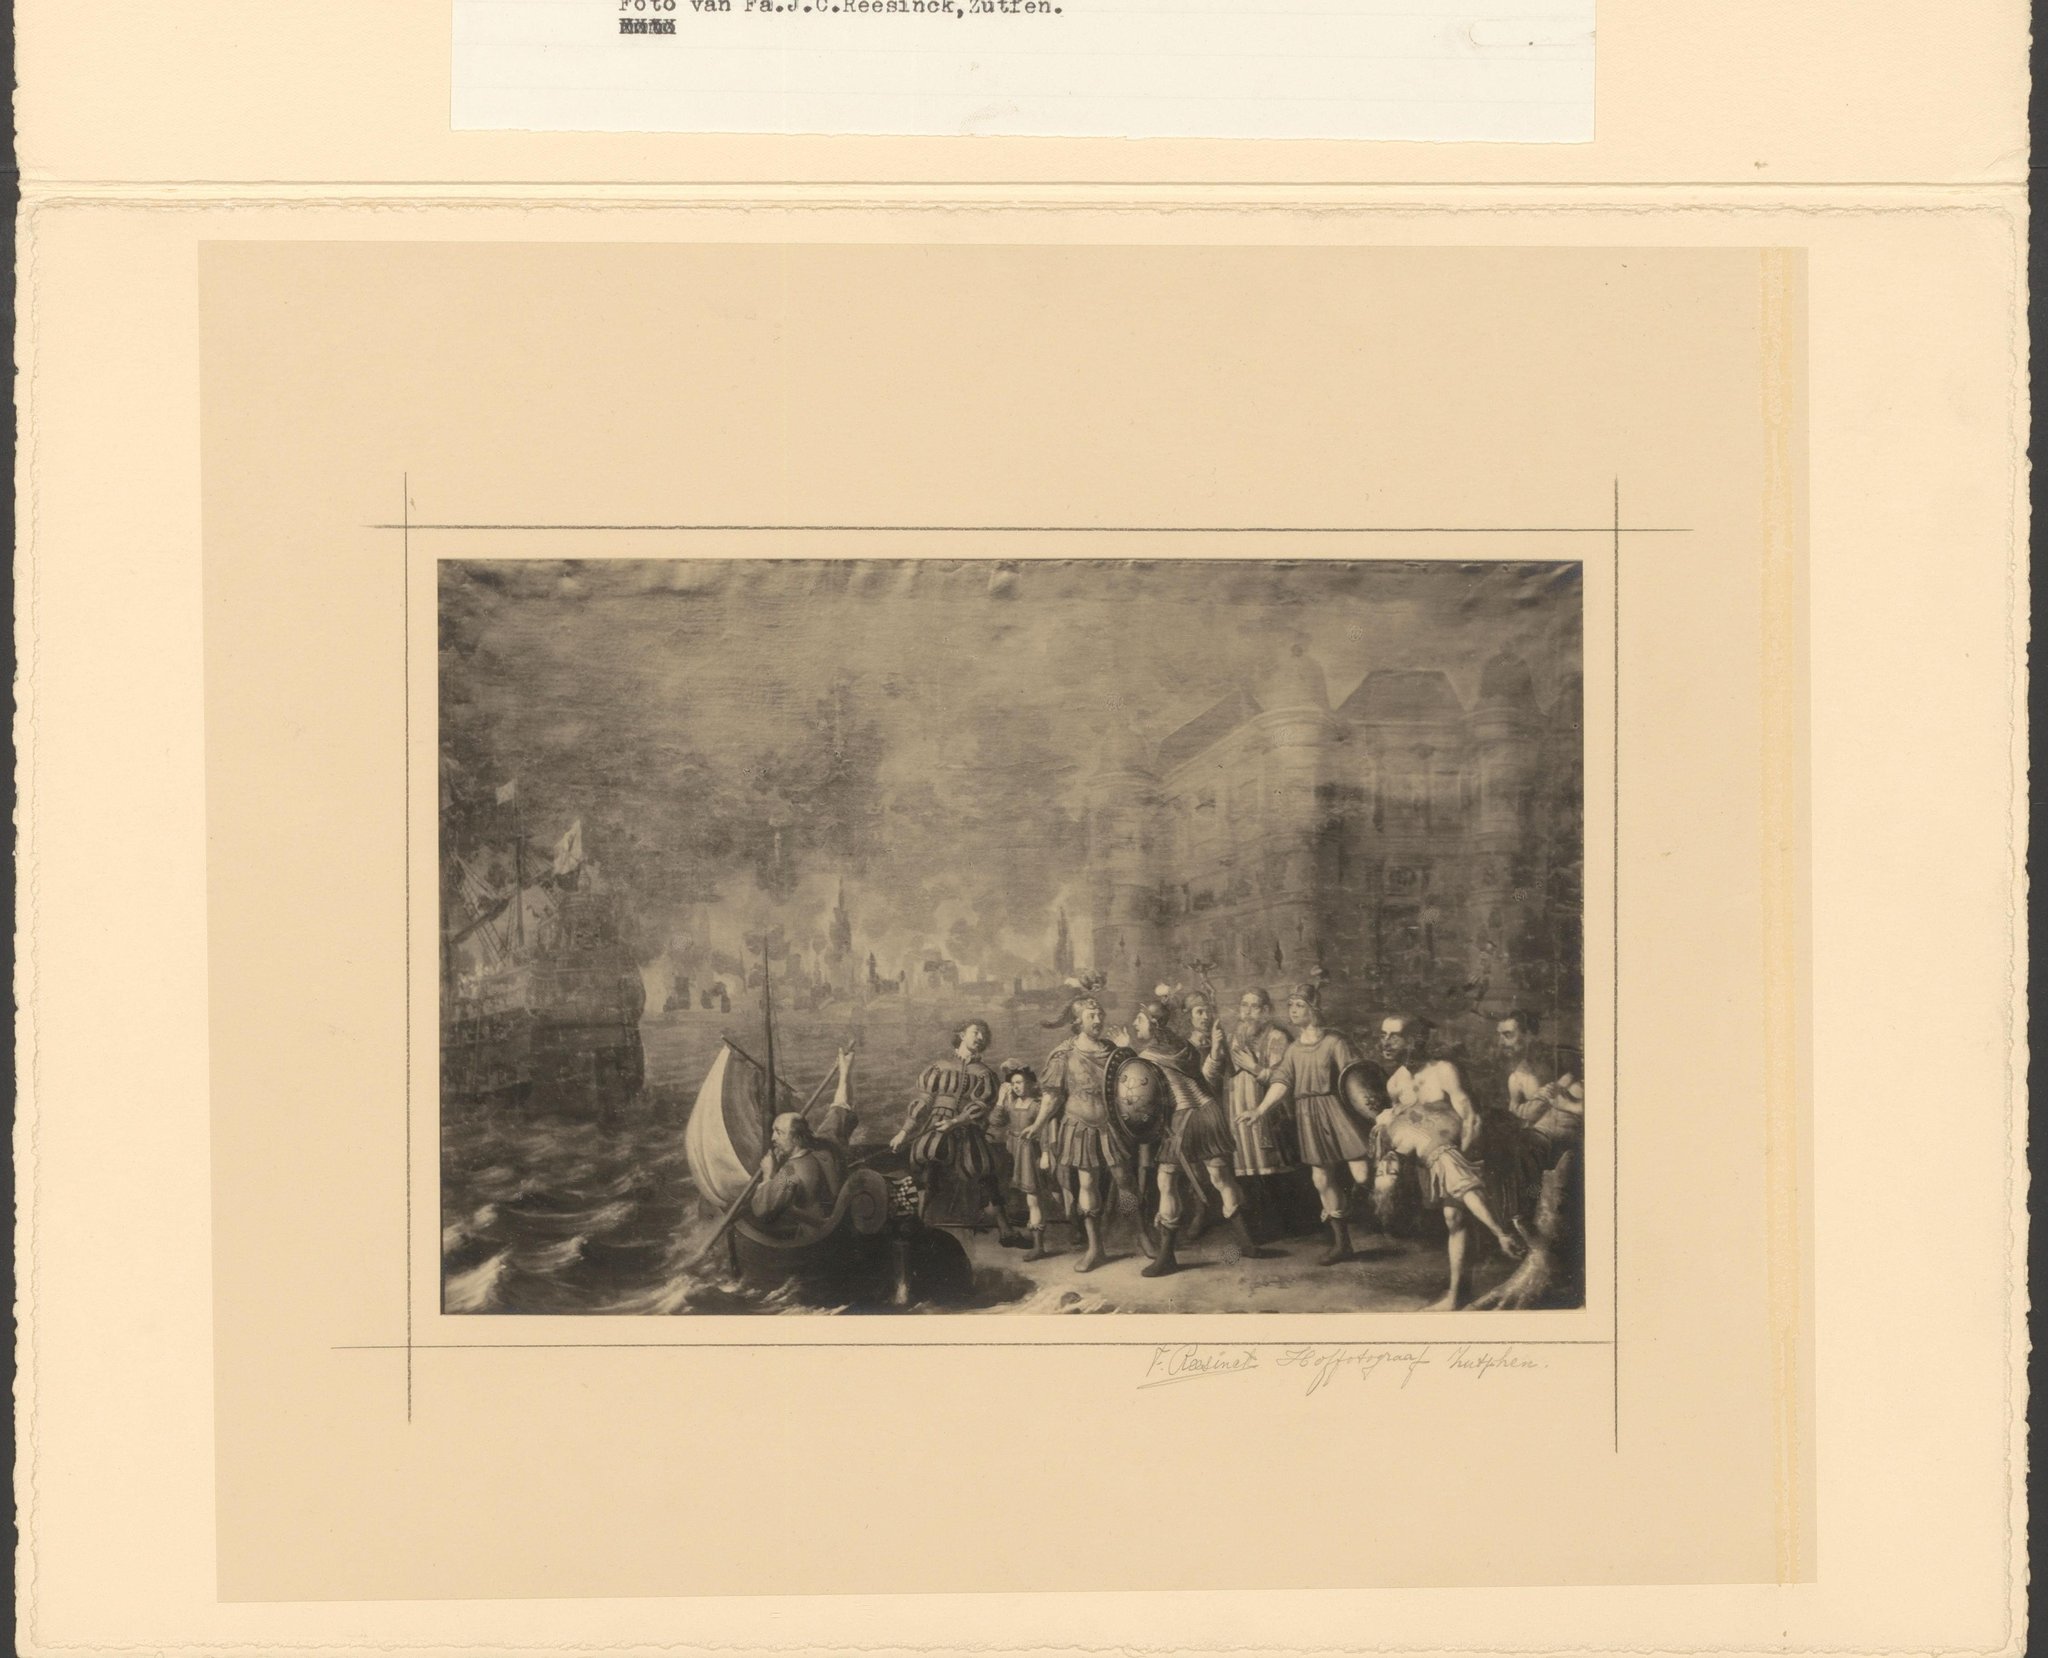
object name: photograph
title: Vlucht van Gijsbrecht van Amstel uit de brandende stad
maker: johan christiaan reesinck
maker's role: fotograaf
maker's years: 1838-1922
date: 1896-1913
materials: paper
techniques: gelatin silver print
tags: theatre, theatrical performance, flight, running away; pursuing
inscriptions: stamp, collector's mark: Lugt 1641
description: Onderwerpsrubrieken binnen de Atlas Zeden en Gewoonten: Tooneel, Scènes en figuren uit bekende toneelspellen.